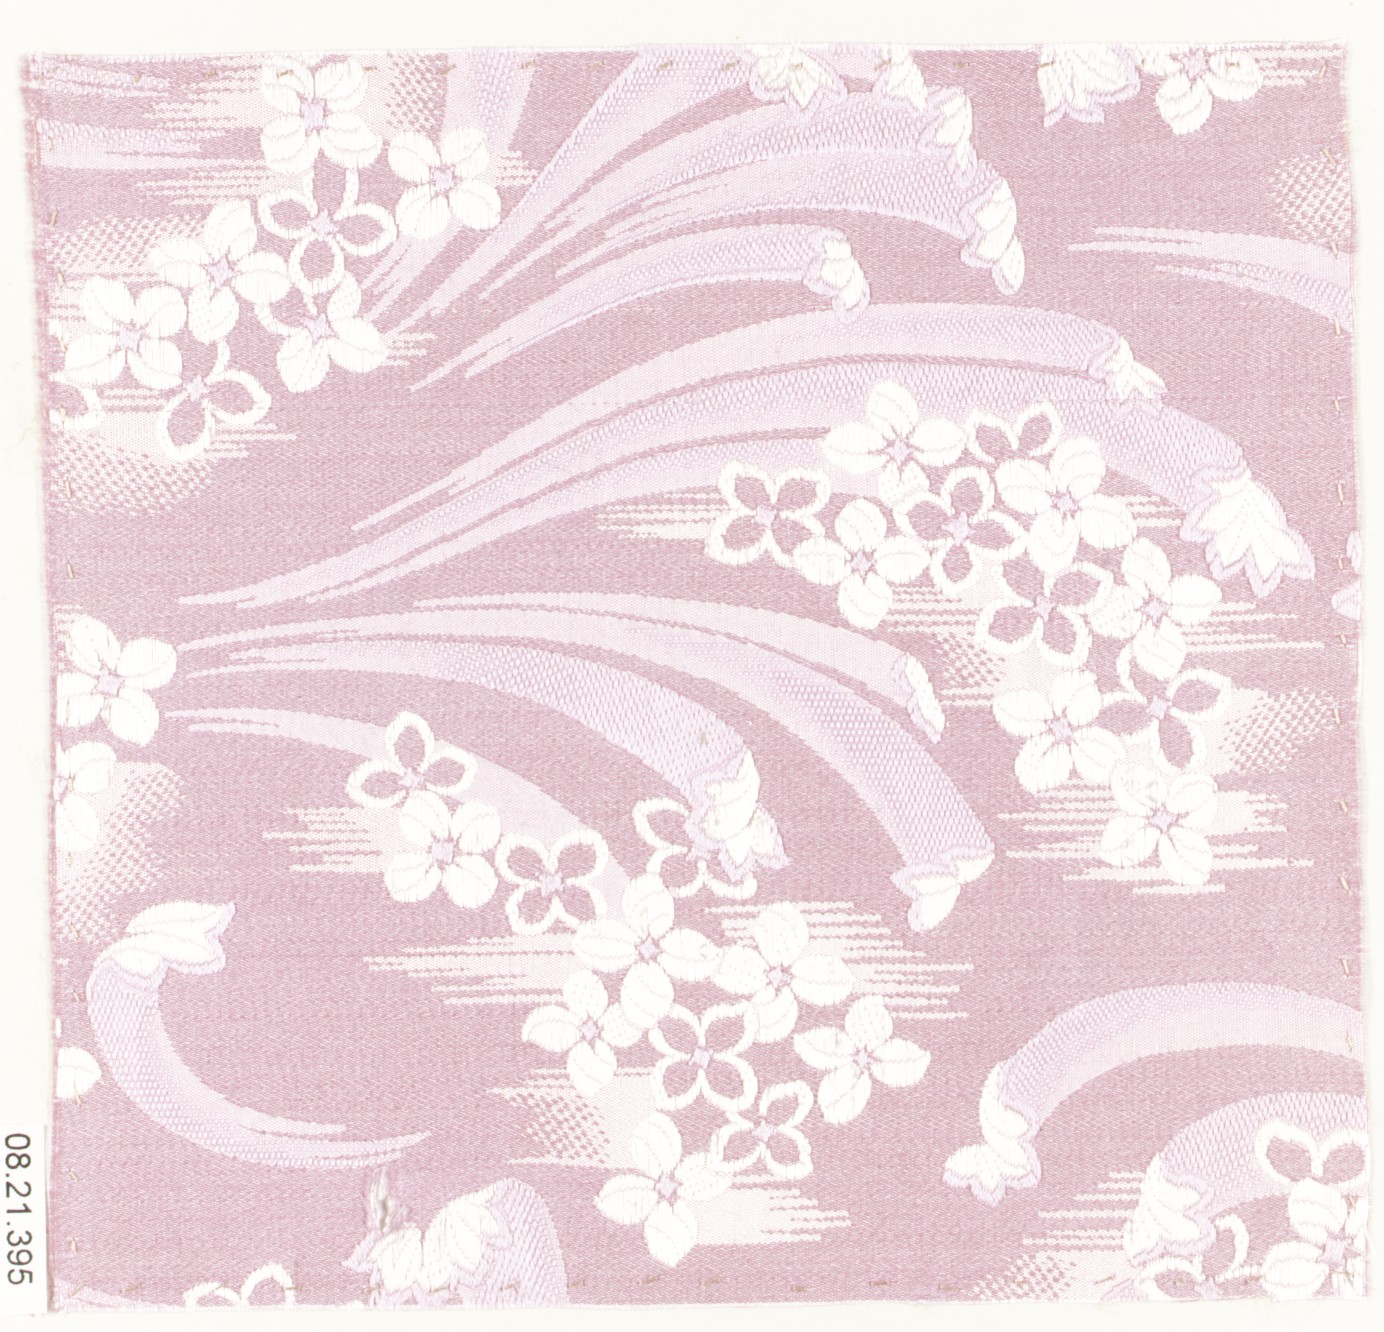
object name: textile sample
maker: Anonymous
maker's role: designer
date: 1900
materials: silk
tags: flowers